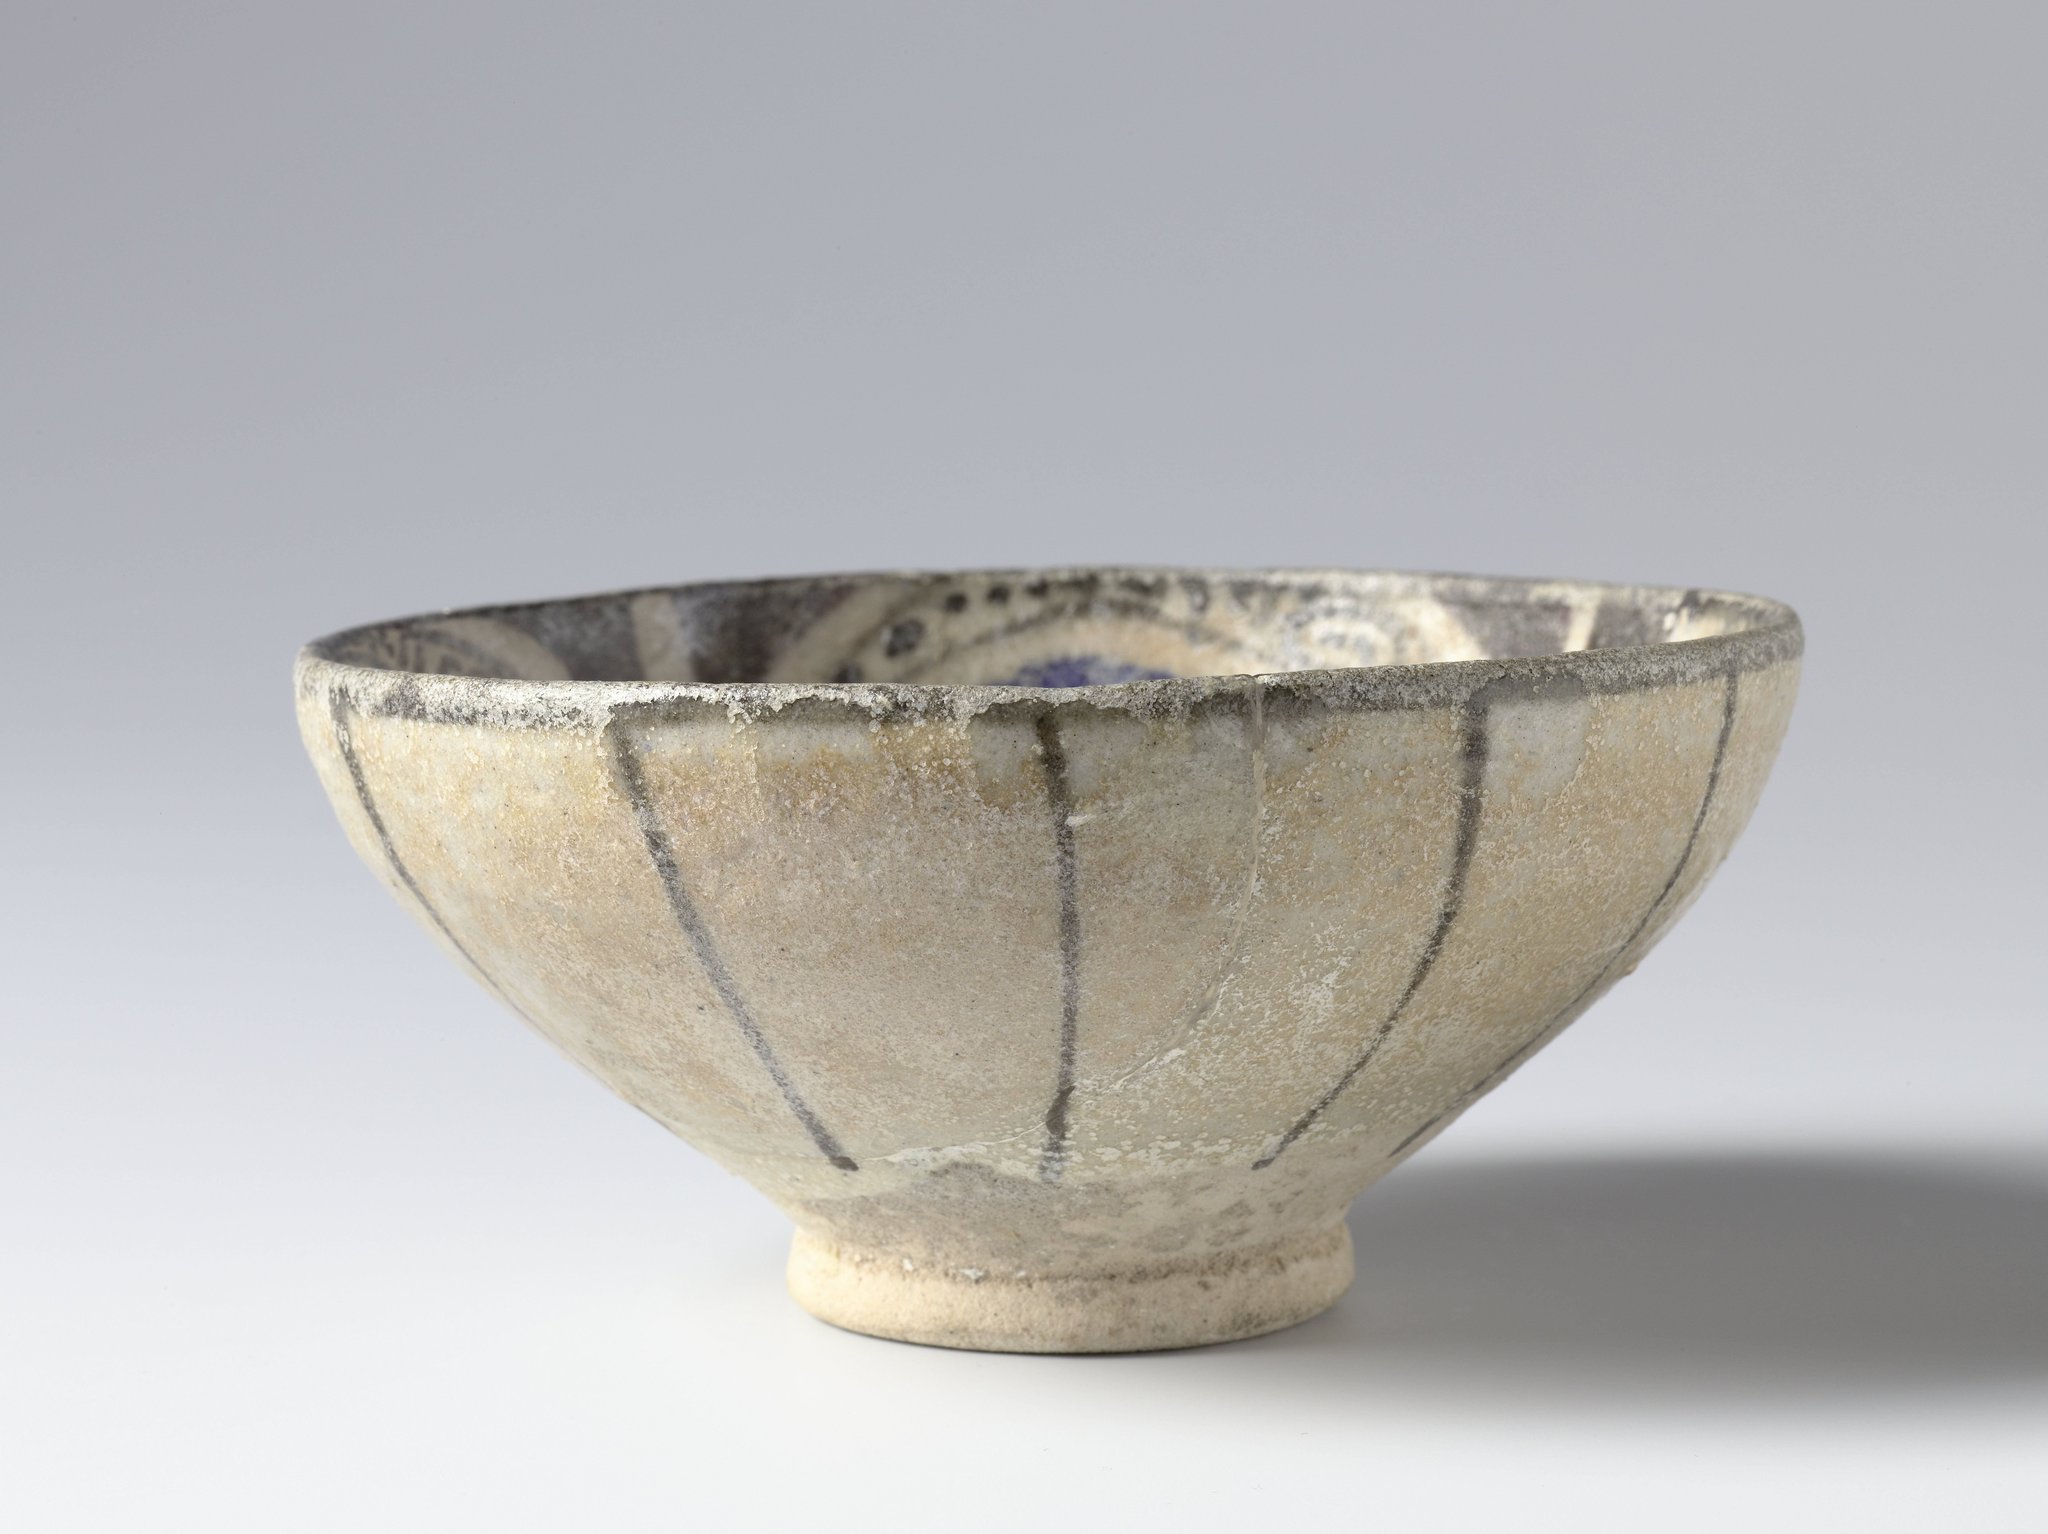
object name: bowl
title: Bowl with a geomatrical pattern in four panels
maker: Anonymous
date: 1200-1399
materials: cobalt, earthenware, glaze, paint, quartz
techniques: firing, turning, vitrification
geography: syria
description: Kom van kwarts-fritgoed met een geometrische decoratie in bruin en blauw onder de transparante alkaliglazuur.